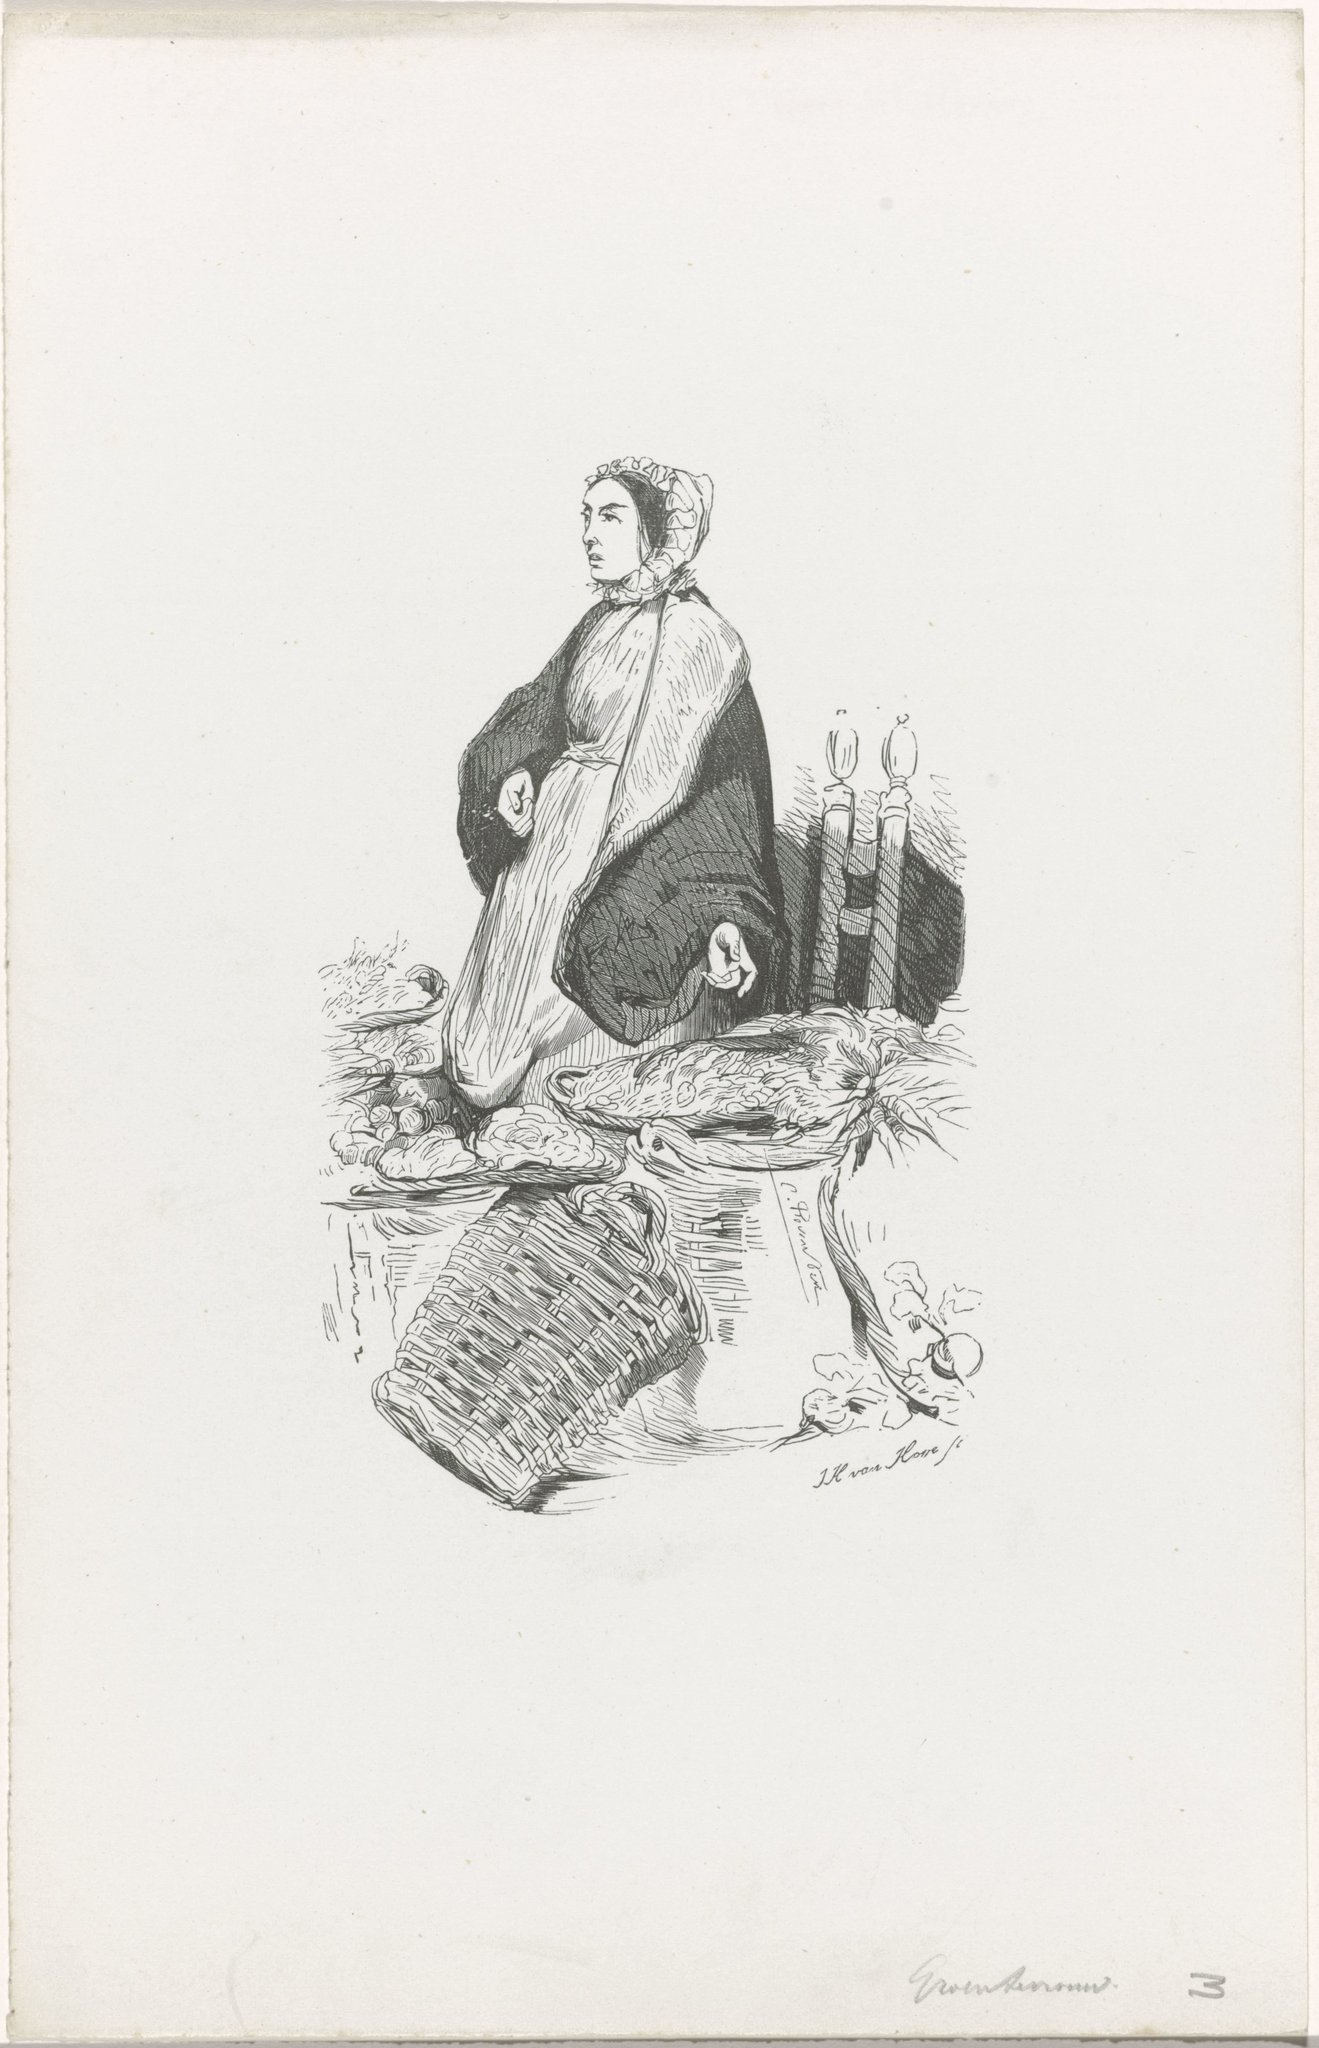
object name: costume print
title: De groentevrouw, 1840-1841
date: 1840-1841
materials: paper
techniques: engraving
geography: netherlands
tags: vegetables, professional clothes, persons engaged in trade and commerce - bb - women engaged in trade and commerce, stall, booth (~ market), netherlands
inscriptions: collector's mark: Lugt 2228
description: Door Muller opgenomen als illustraties die wel gemaakt zijn voor, maar uiteindelijk niet zijn gebruikt in het boek: De Nederlanden : karakterschetsen, kleederdrachten, houding en voorkomen van verschillende standen : tekst van de meest geachte schrijvers : met gravuren van Henry Brown naar teekeningen van de voornaamste Nederlandsche kunstenaars. 's Gravenhage, 1841.